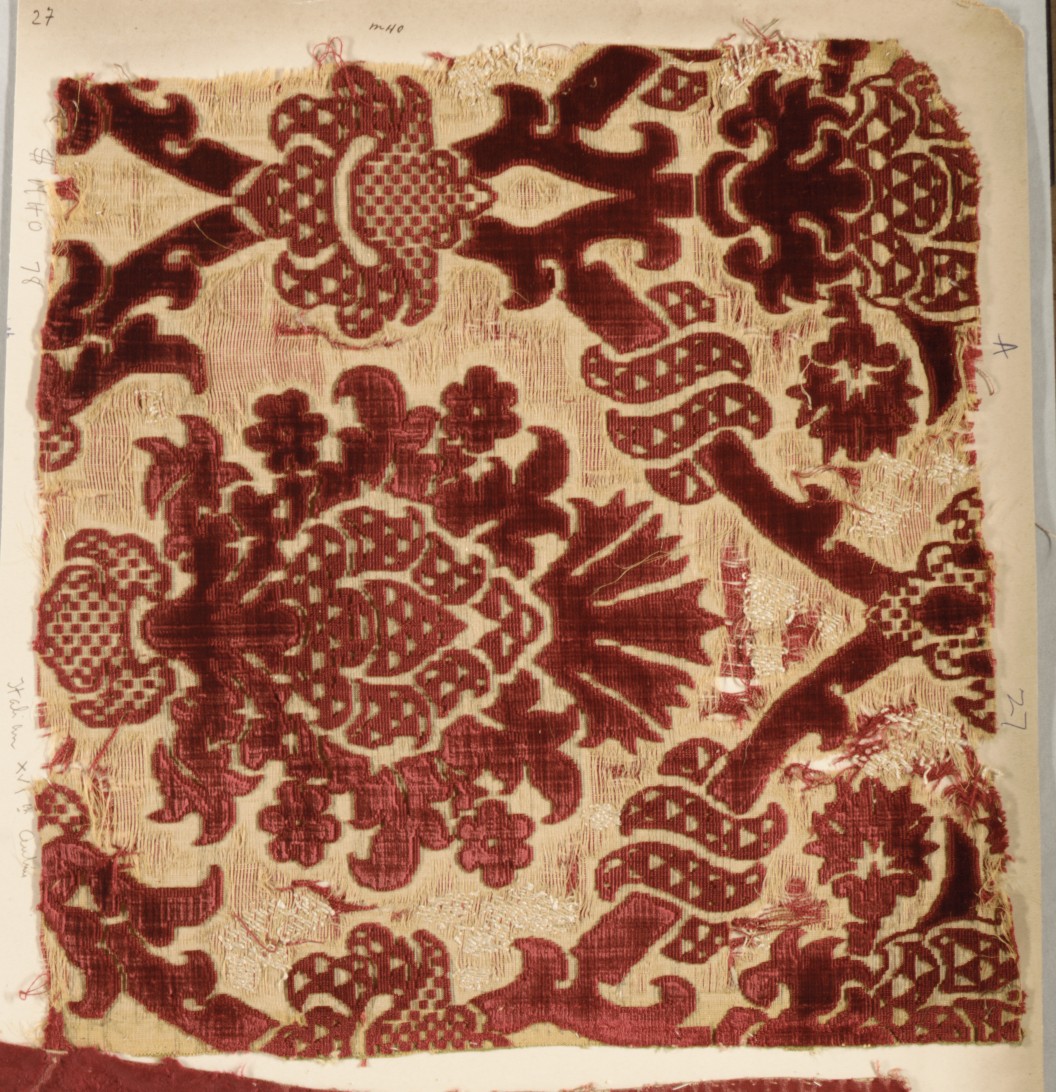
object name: fragment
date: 1501-1600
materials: metal thread, silk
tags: flowers